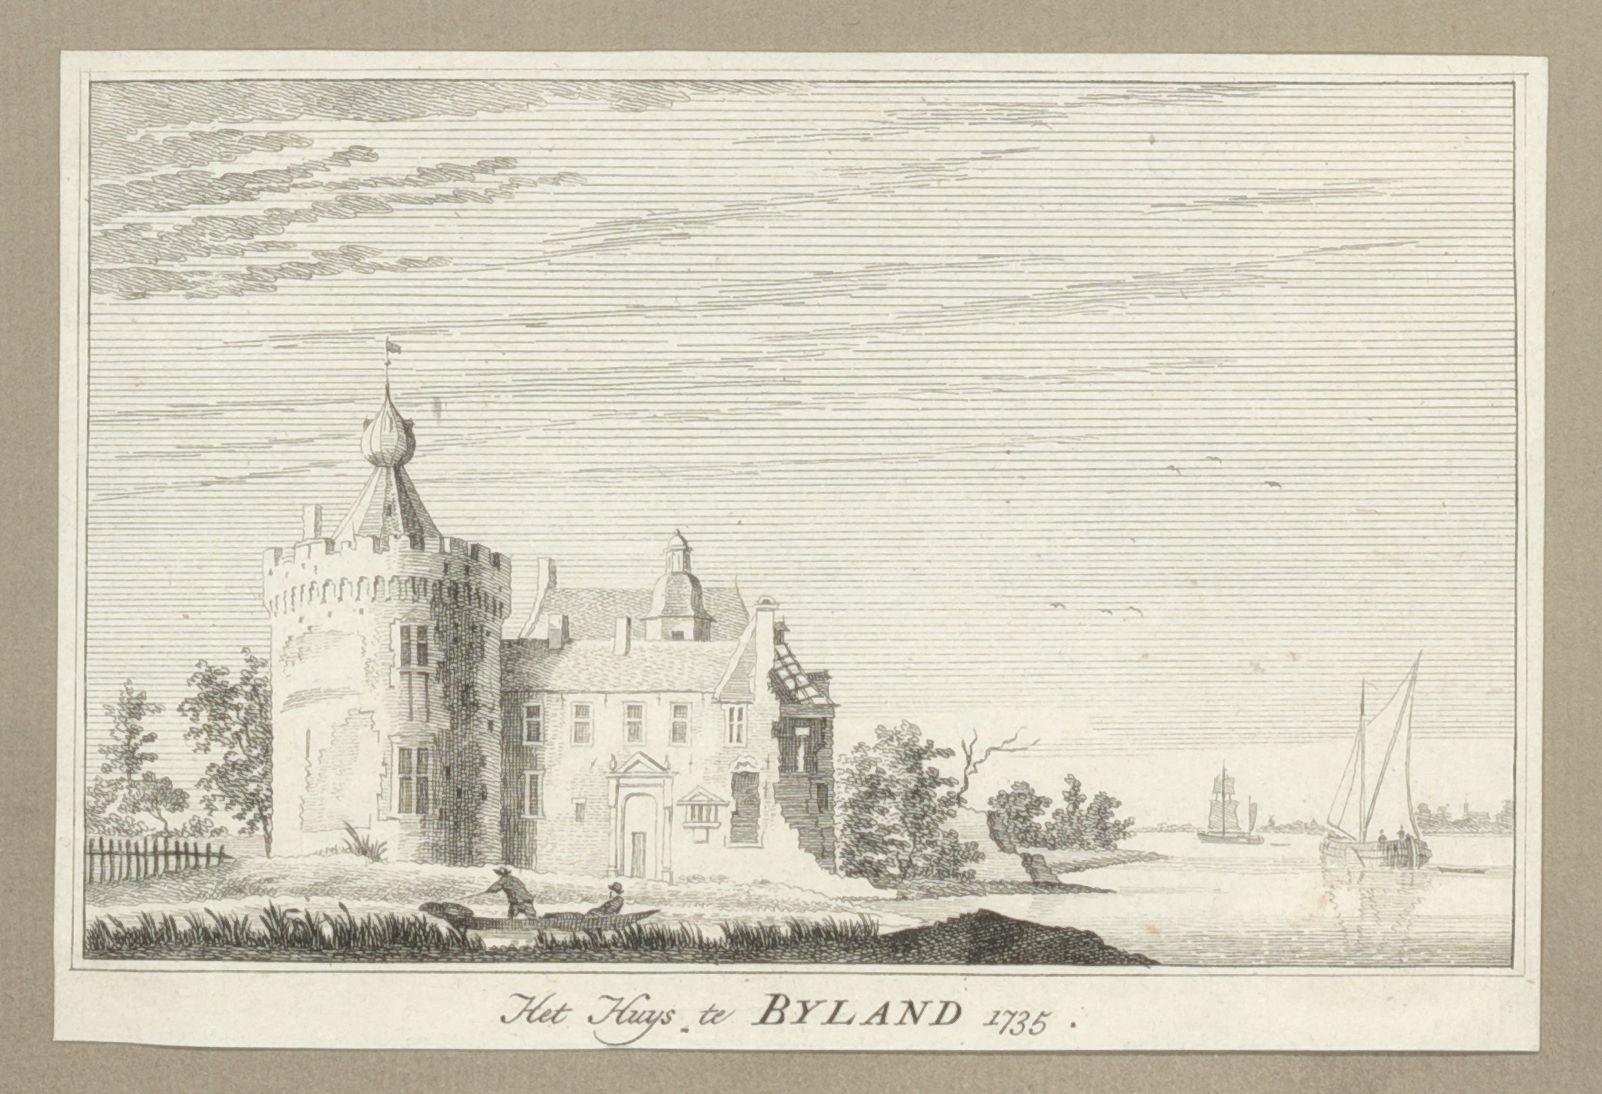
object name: print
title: Dorps- en stadsgezichten te Kleef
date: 1761-1792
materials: paper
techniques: etching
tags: castle, prospect of city, town panorama, silhouette of city, cleves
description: De prent maakt deel uit van een 100-delige serie met gezichten op dorpen en steden te Kleef. Onderwerpsrubrieken binnen de Atlas Zeden en Gewoonten: Zeden en Gewoonten in Engeren Zin, De Woning. Kastelen en buitenplaatsen. Over de Grenzen.